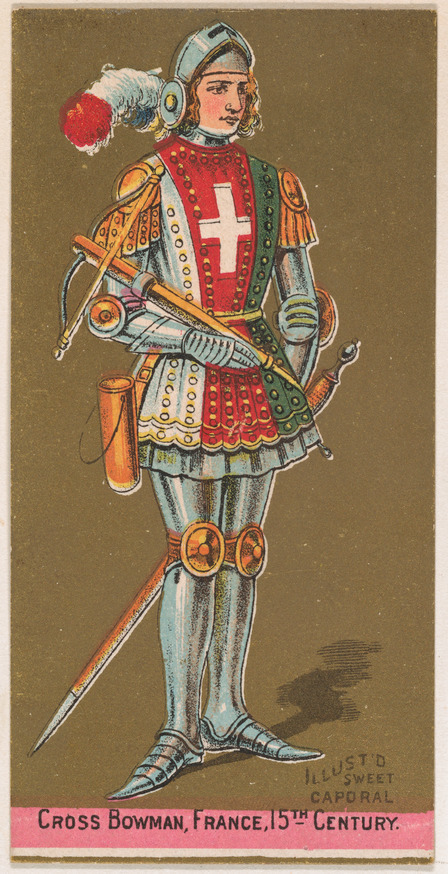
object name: print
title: Cross Bowman, France, 15th Century, from the Military Series (N224) issued by Kinney Tobacco Company to promote Sweet Caporal Cigarettes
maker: kinney brothers tobacco company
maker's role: publisher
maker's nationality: american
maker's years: 1869-2011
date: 1888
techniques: color lithograph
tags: soldiers,armor,swords,men